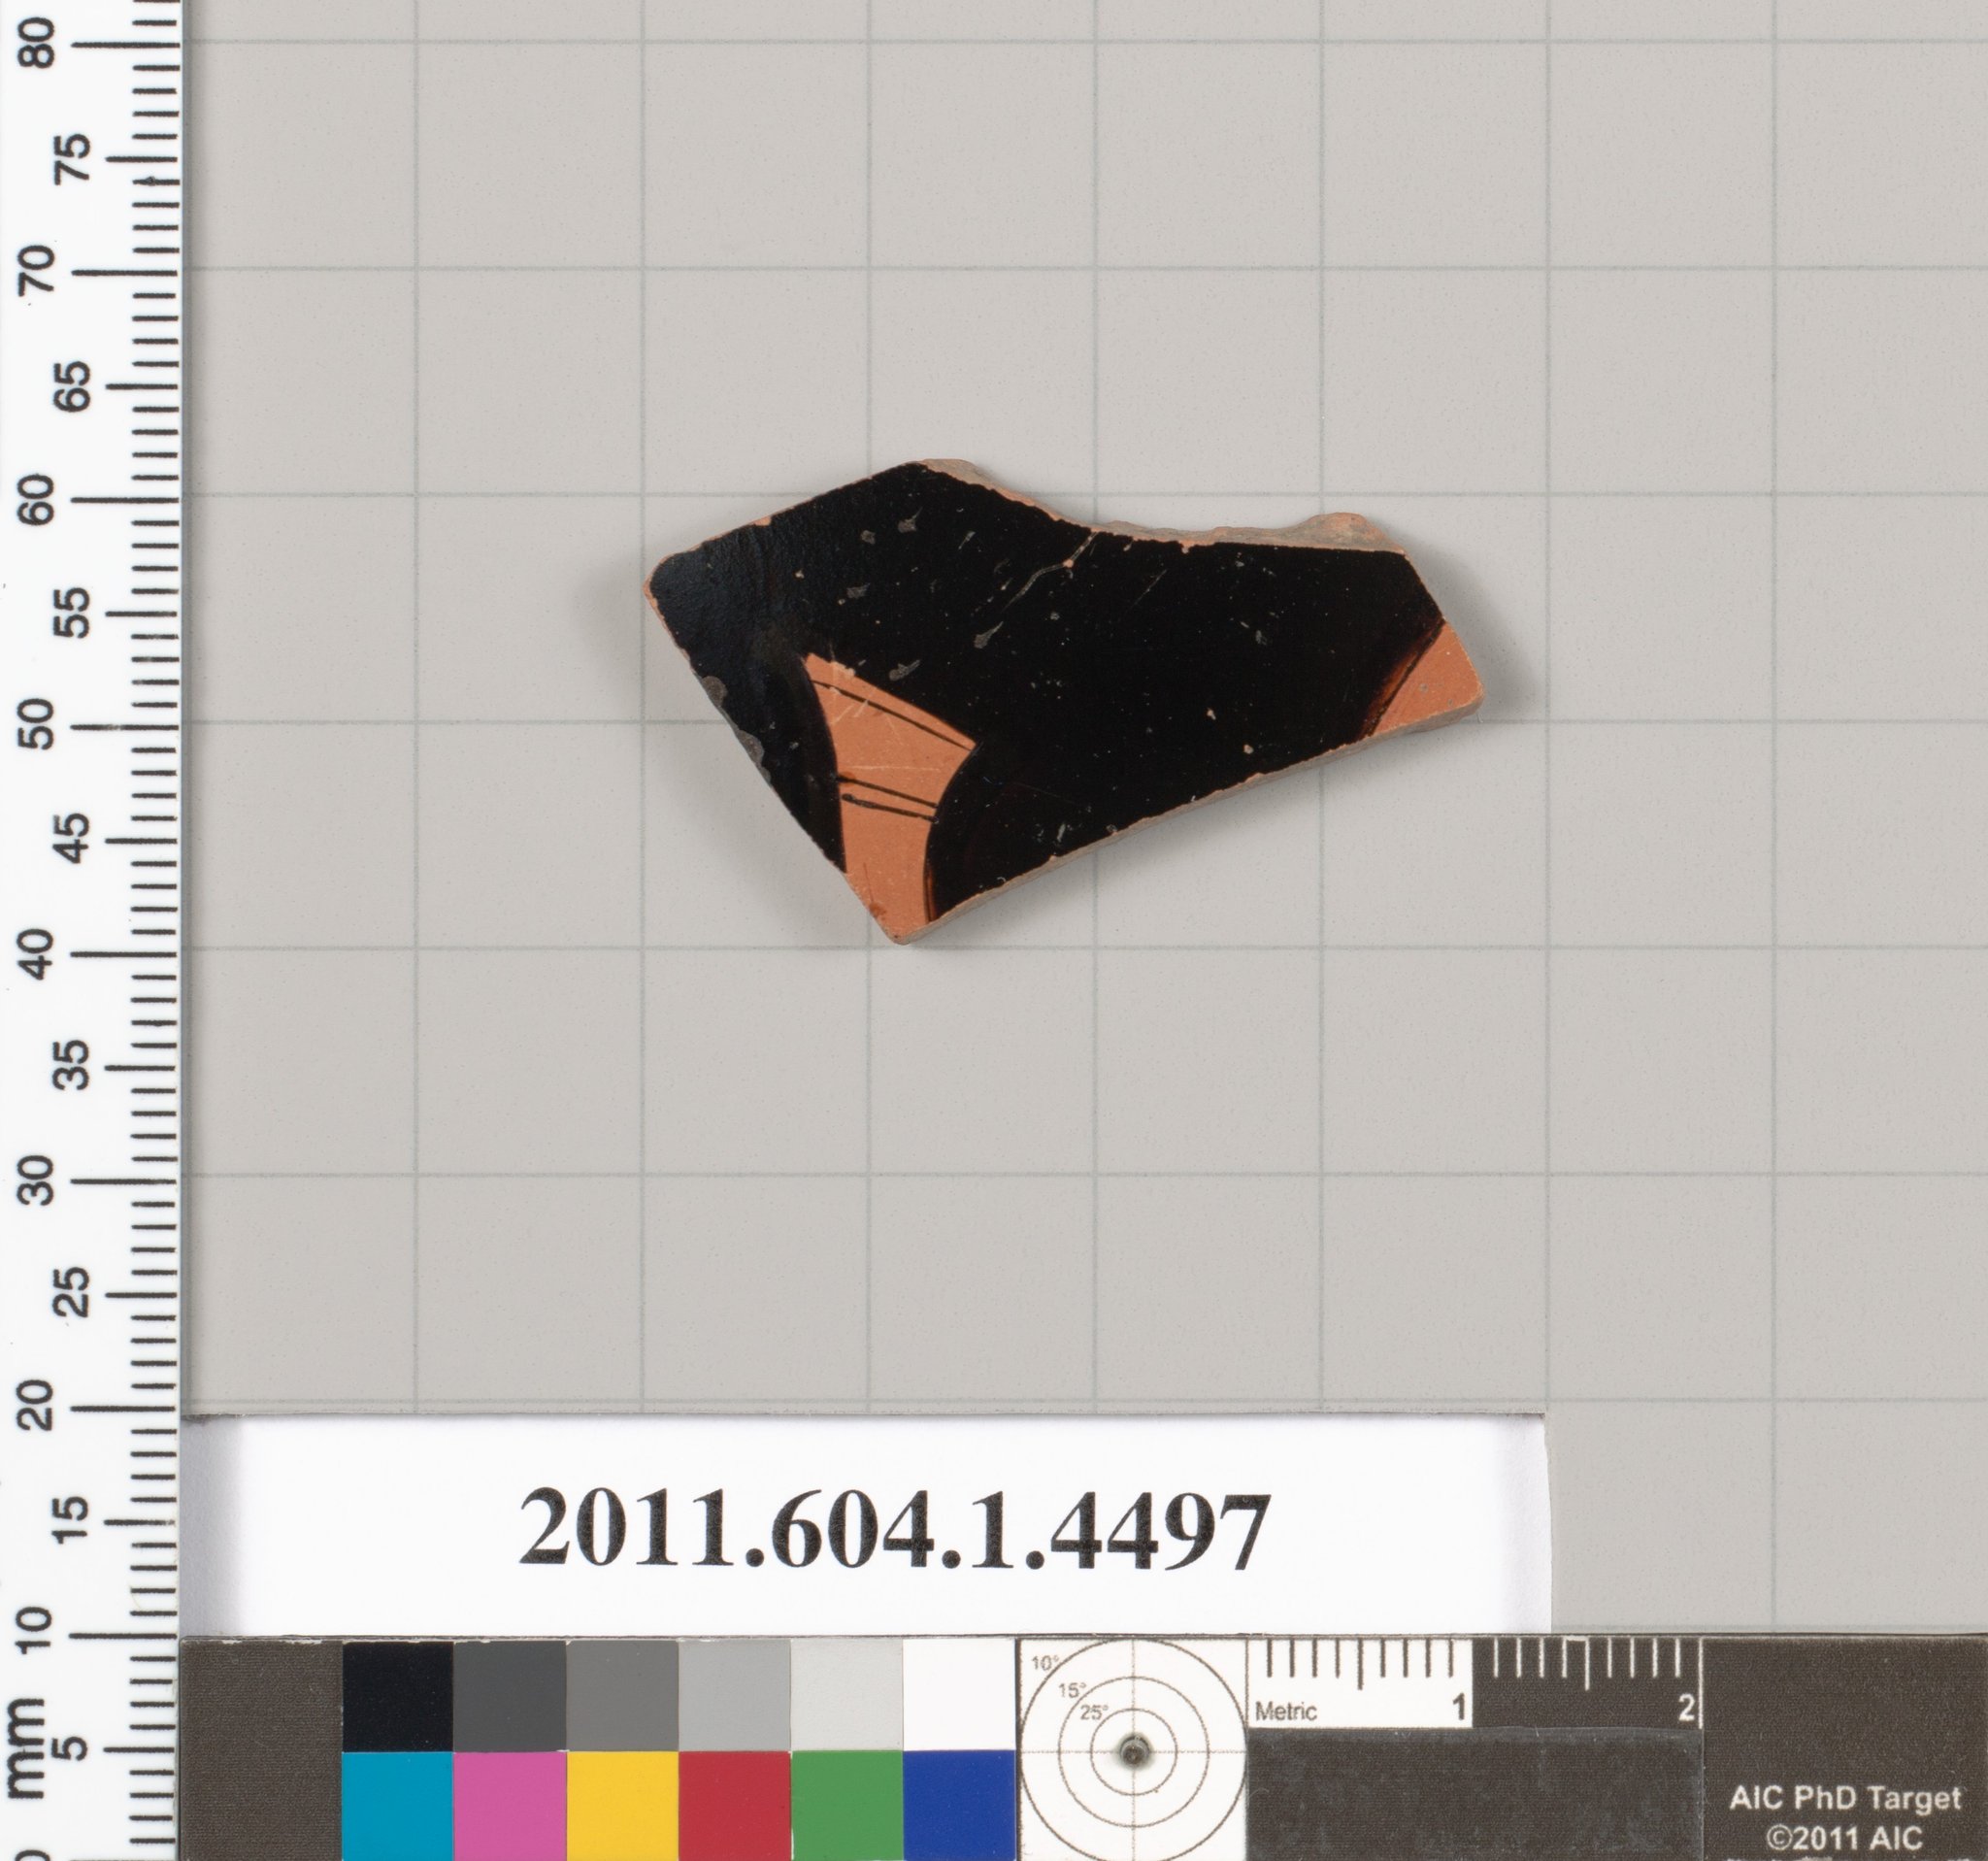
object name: kylix fragment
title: Terracotta fragment of a kylix (drinking cup)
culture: greek, attic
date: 480-470 BCE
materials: terracotta